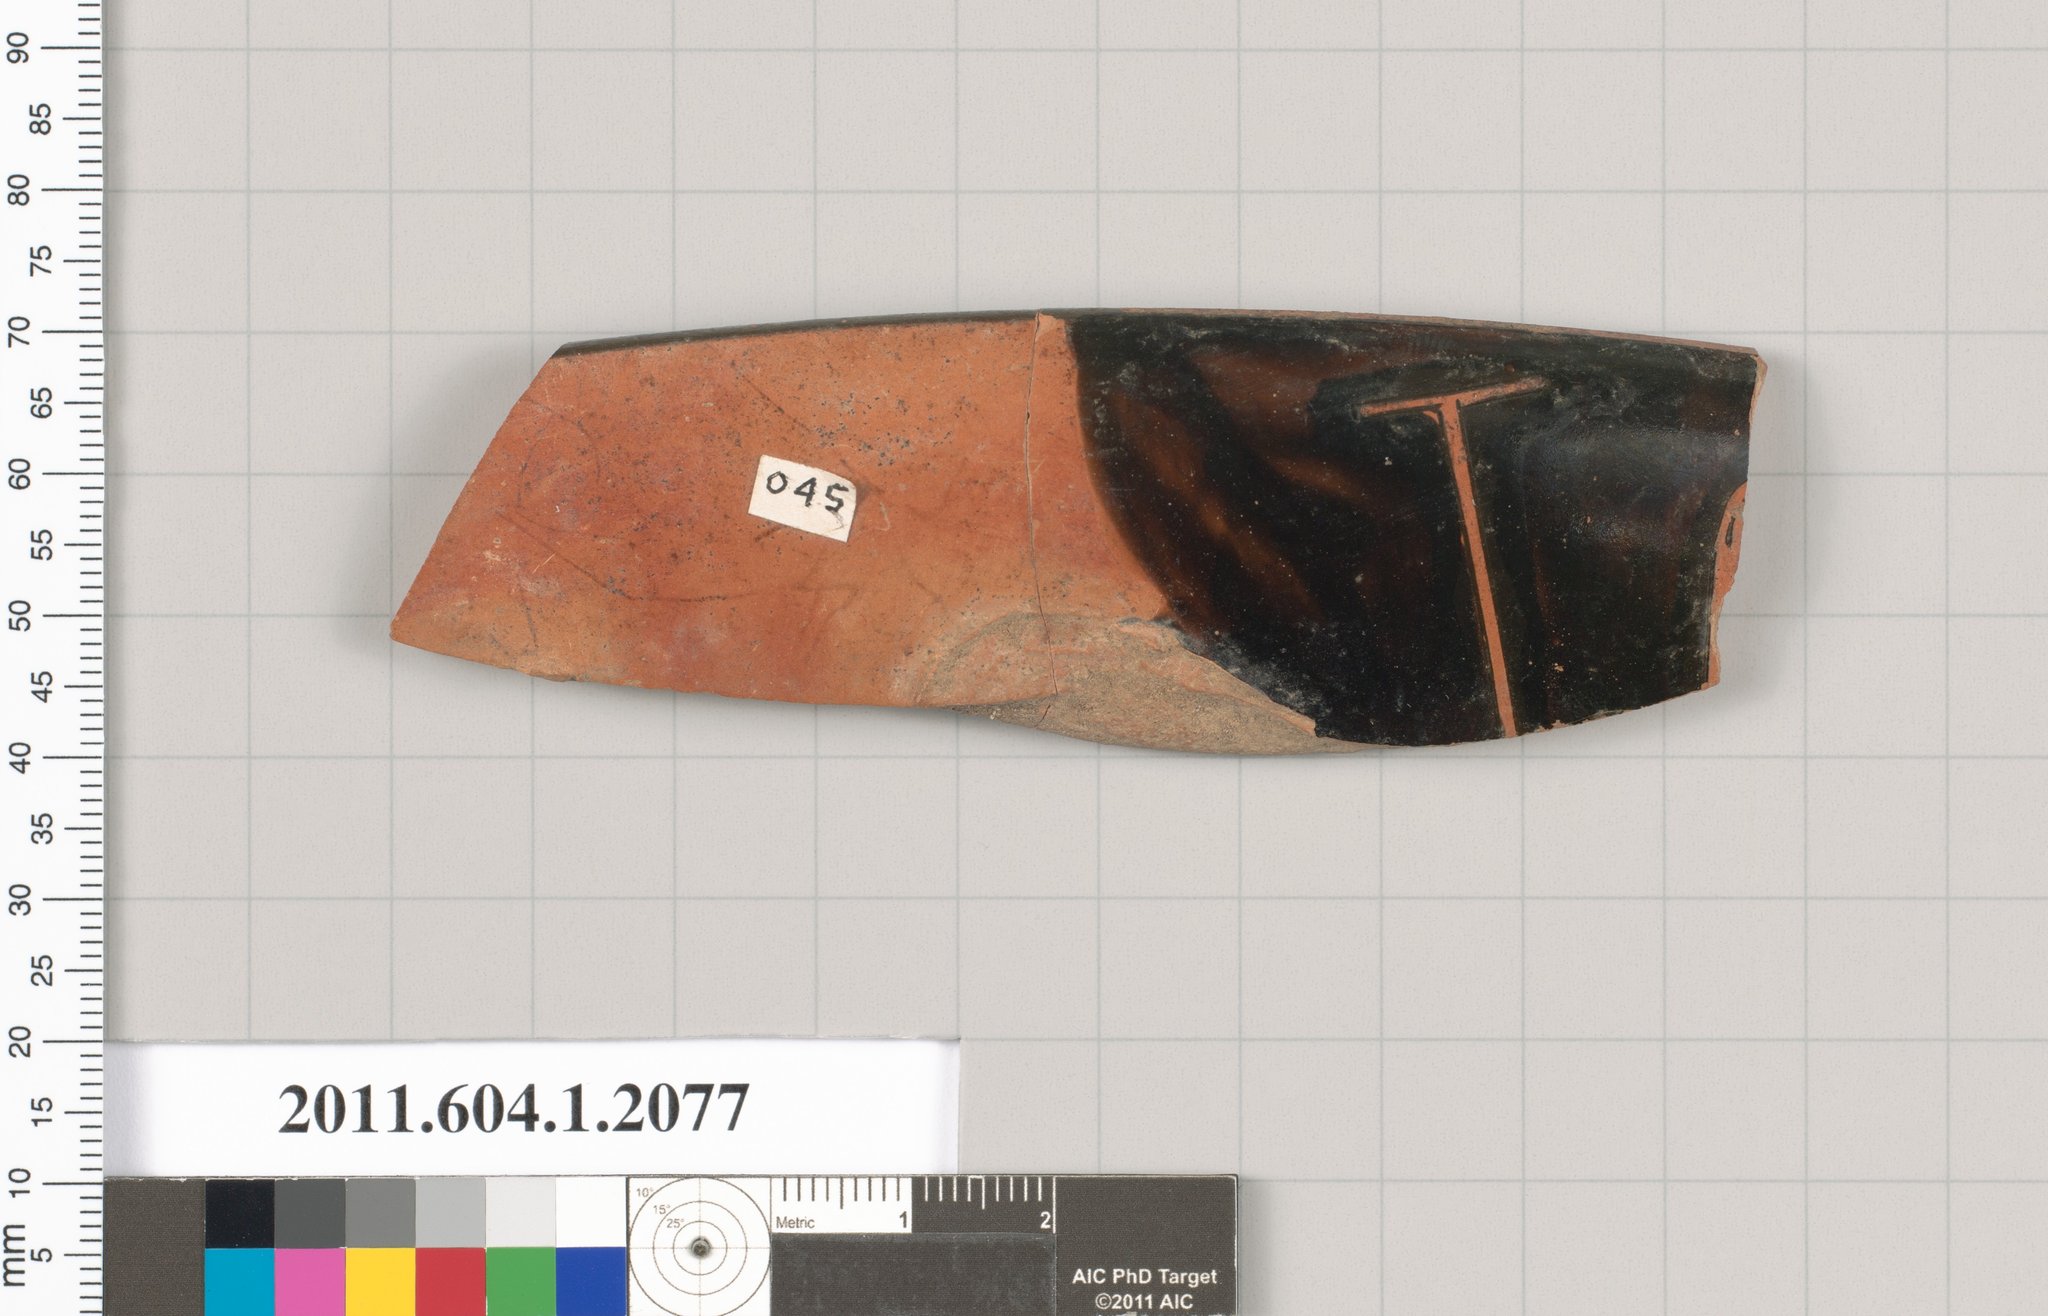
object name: kylix fragment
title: Terracotta rim fragment of a kylix (drinking cup)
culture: greek, attic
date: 475-451 BCE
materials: terracotta